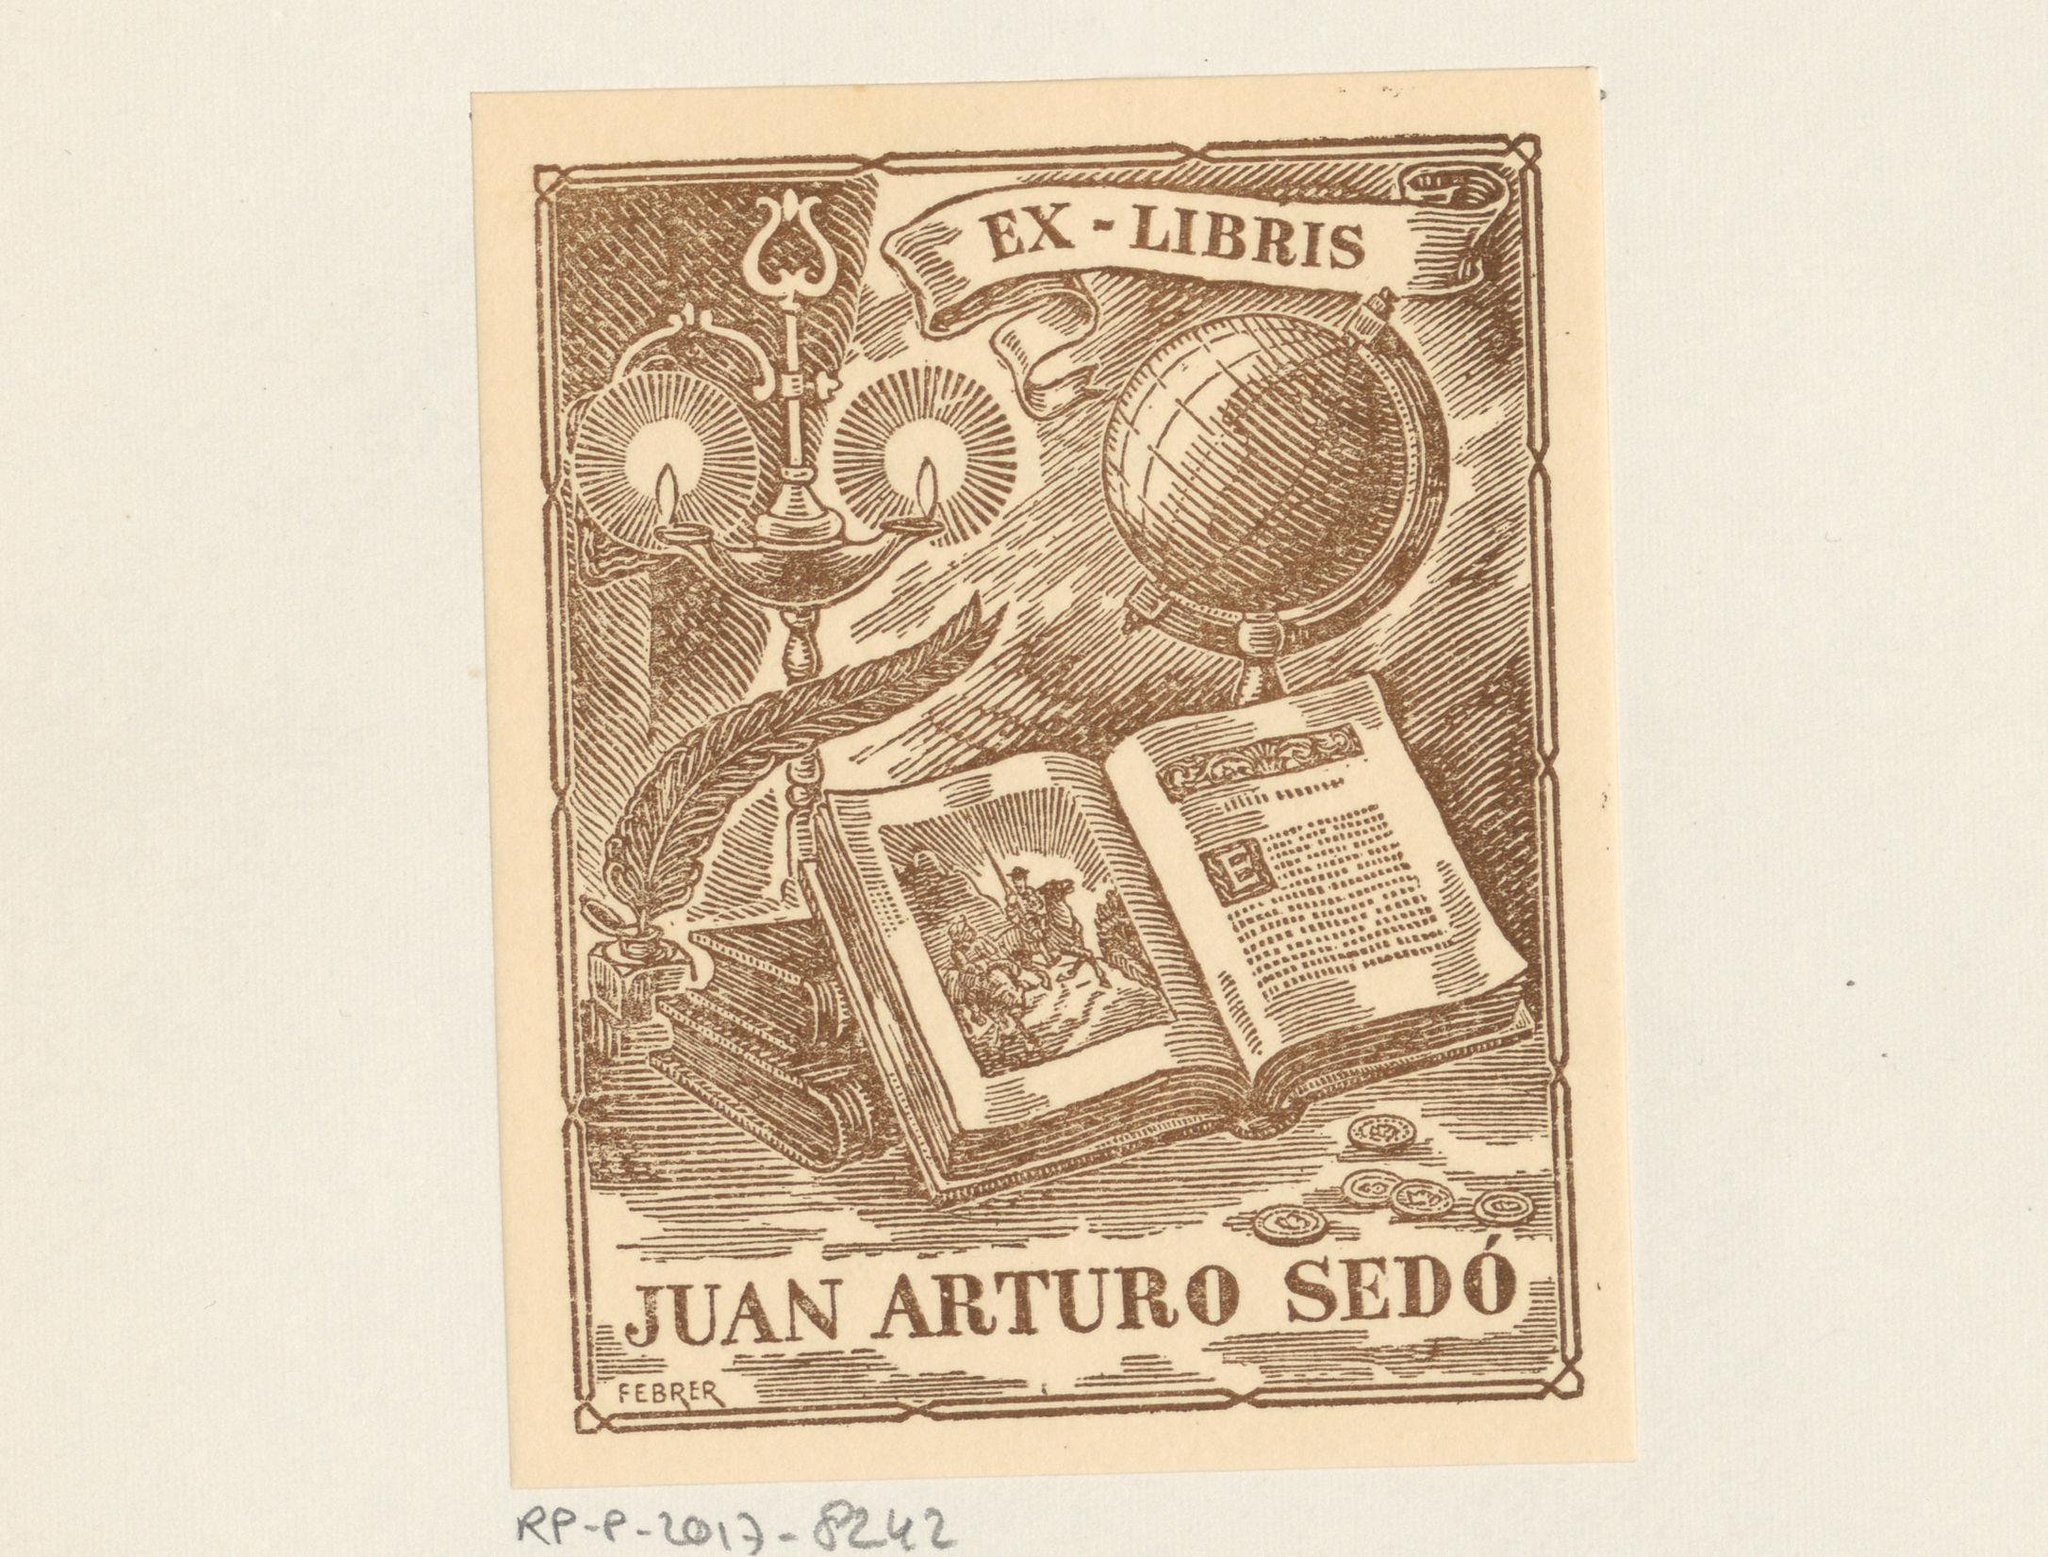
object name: bookplate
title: Ex libris van Juan Arturo Sedó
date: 1900-1949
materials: paper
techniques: printing block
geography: spain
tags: book, oil-lamp, globe